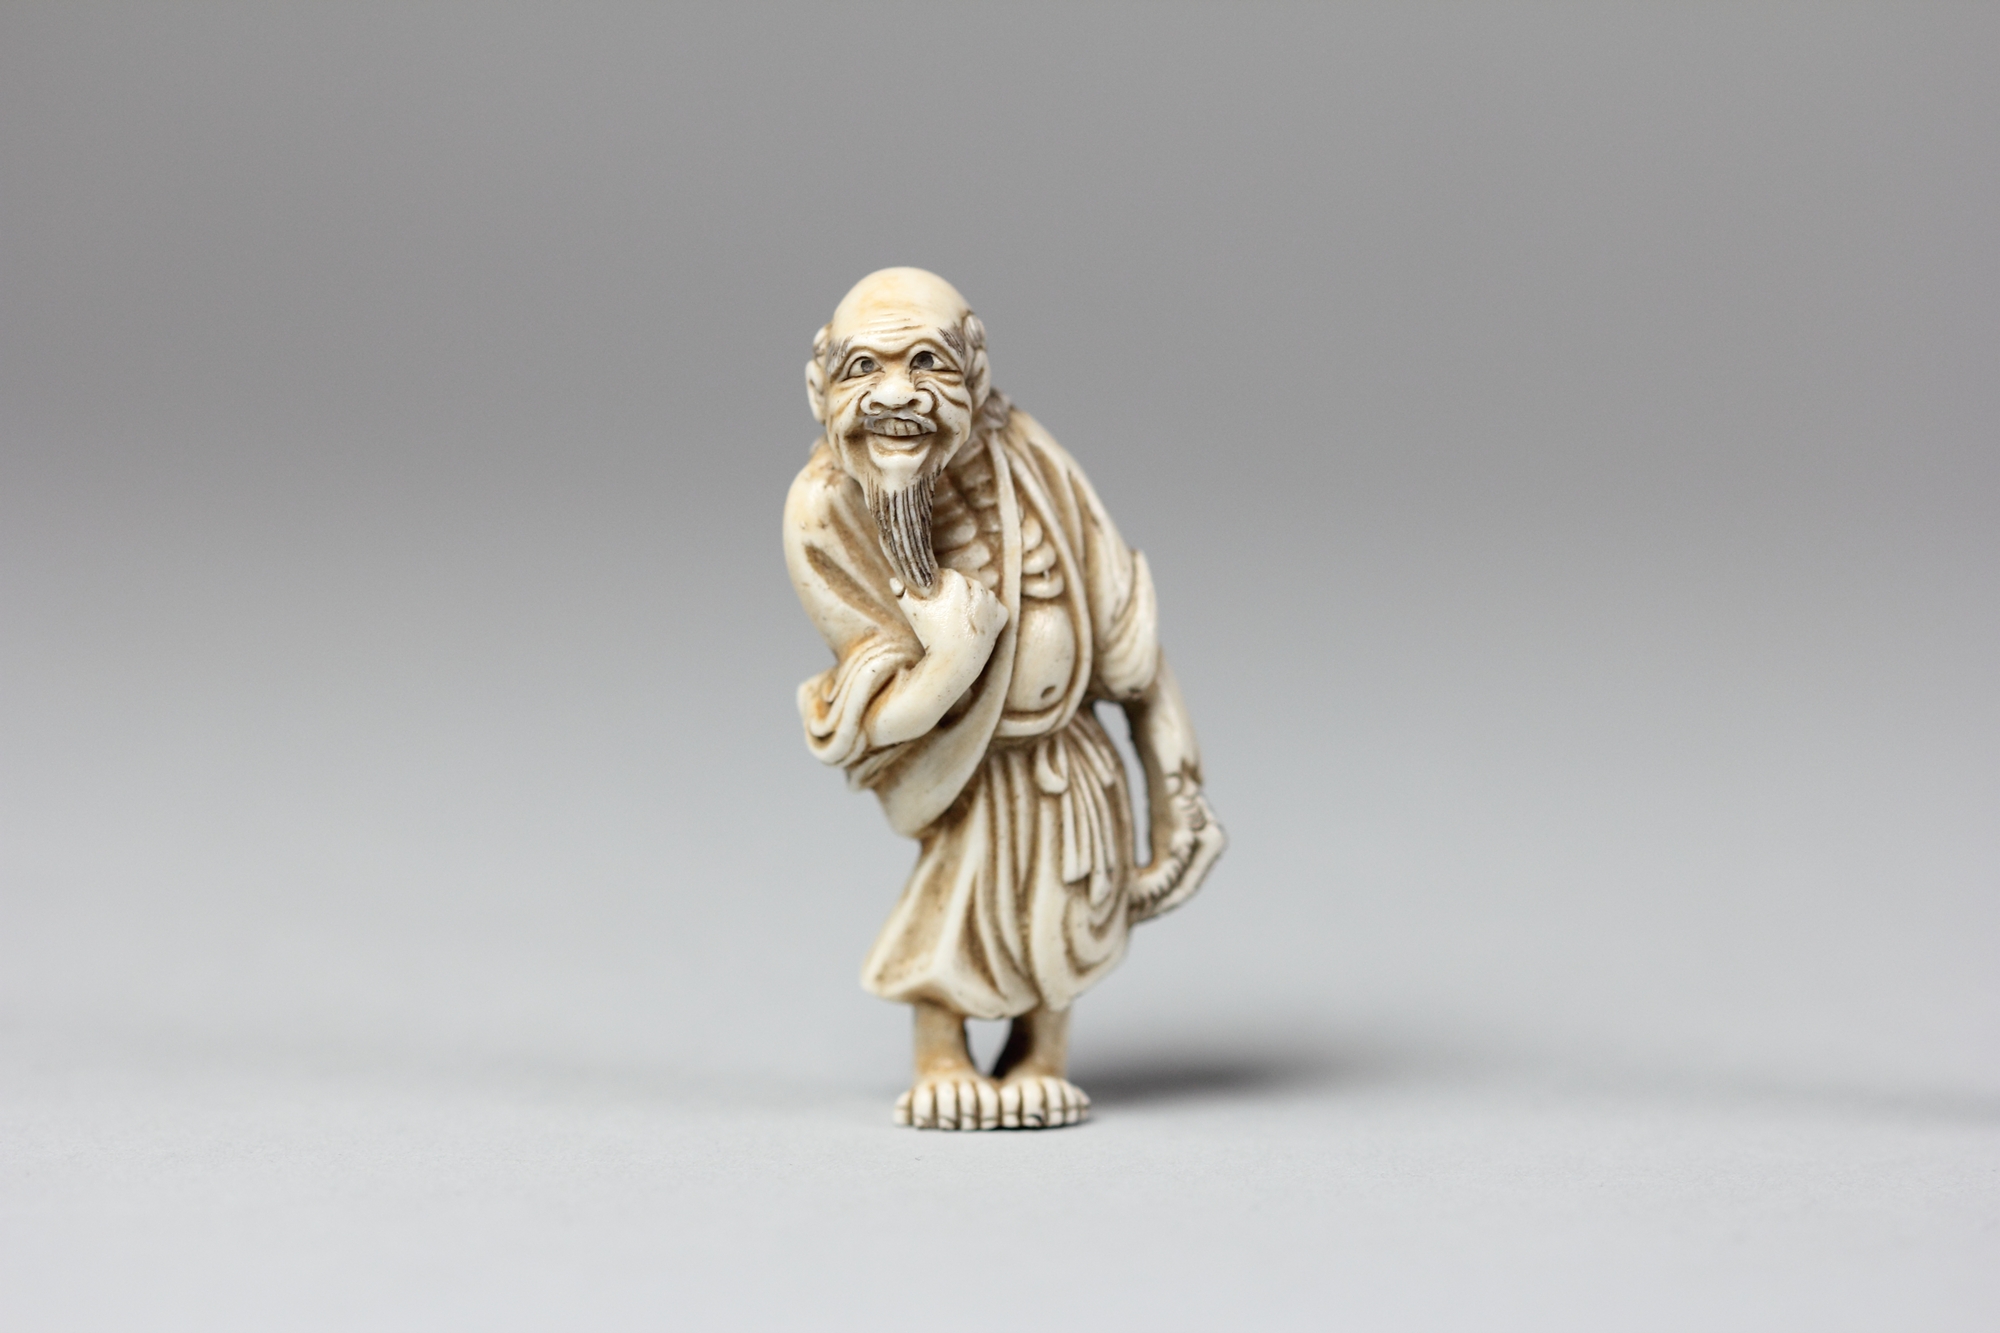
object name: netsuke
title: Netsuke of Old Man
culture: japanese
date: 1701-1900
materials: porcelain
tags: men